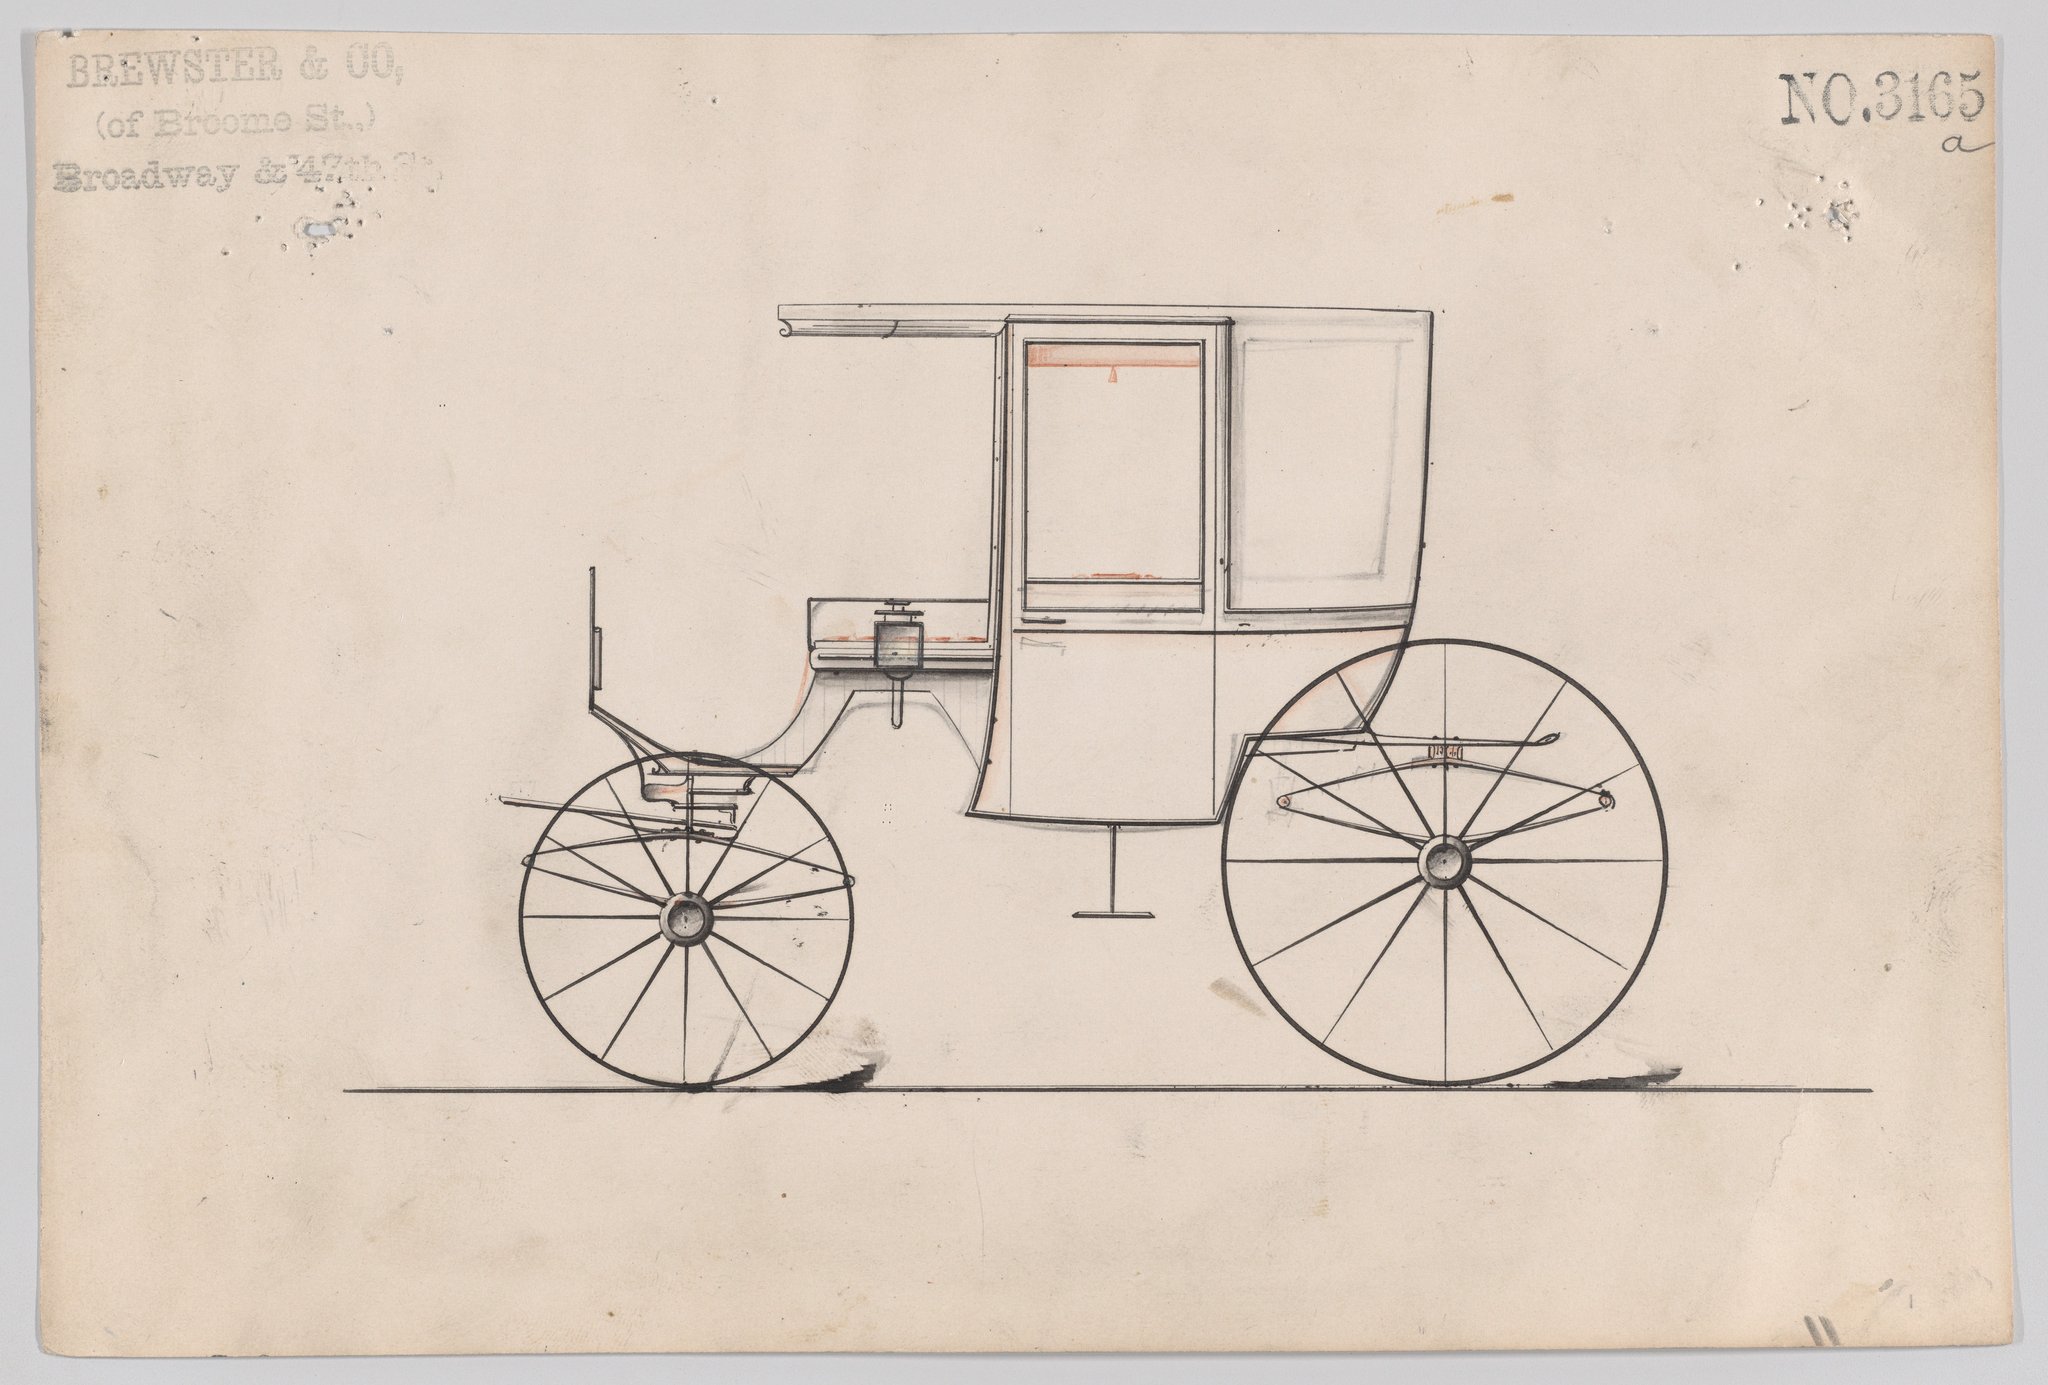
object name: drawing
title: Design for 4 seat Rockaway, no. 3165a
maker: brewster & co.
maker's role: manufacturer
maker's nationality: american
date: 1875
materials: gouache, ink, watercolor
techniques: pen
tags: carriages